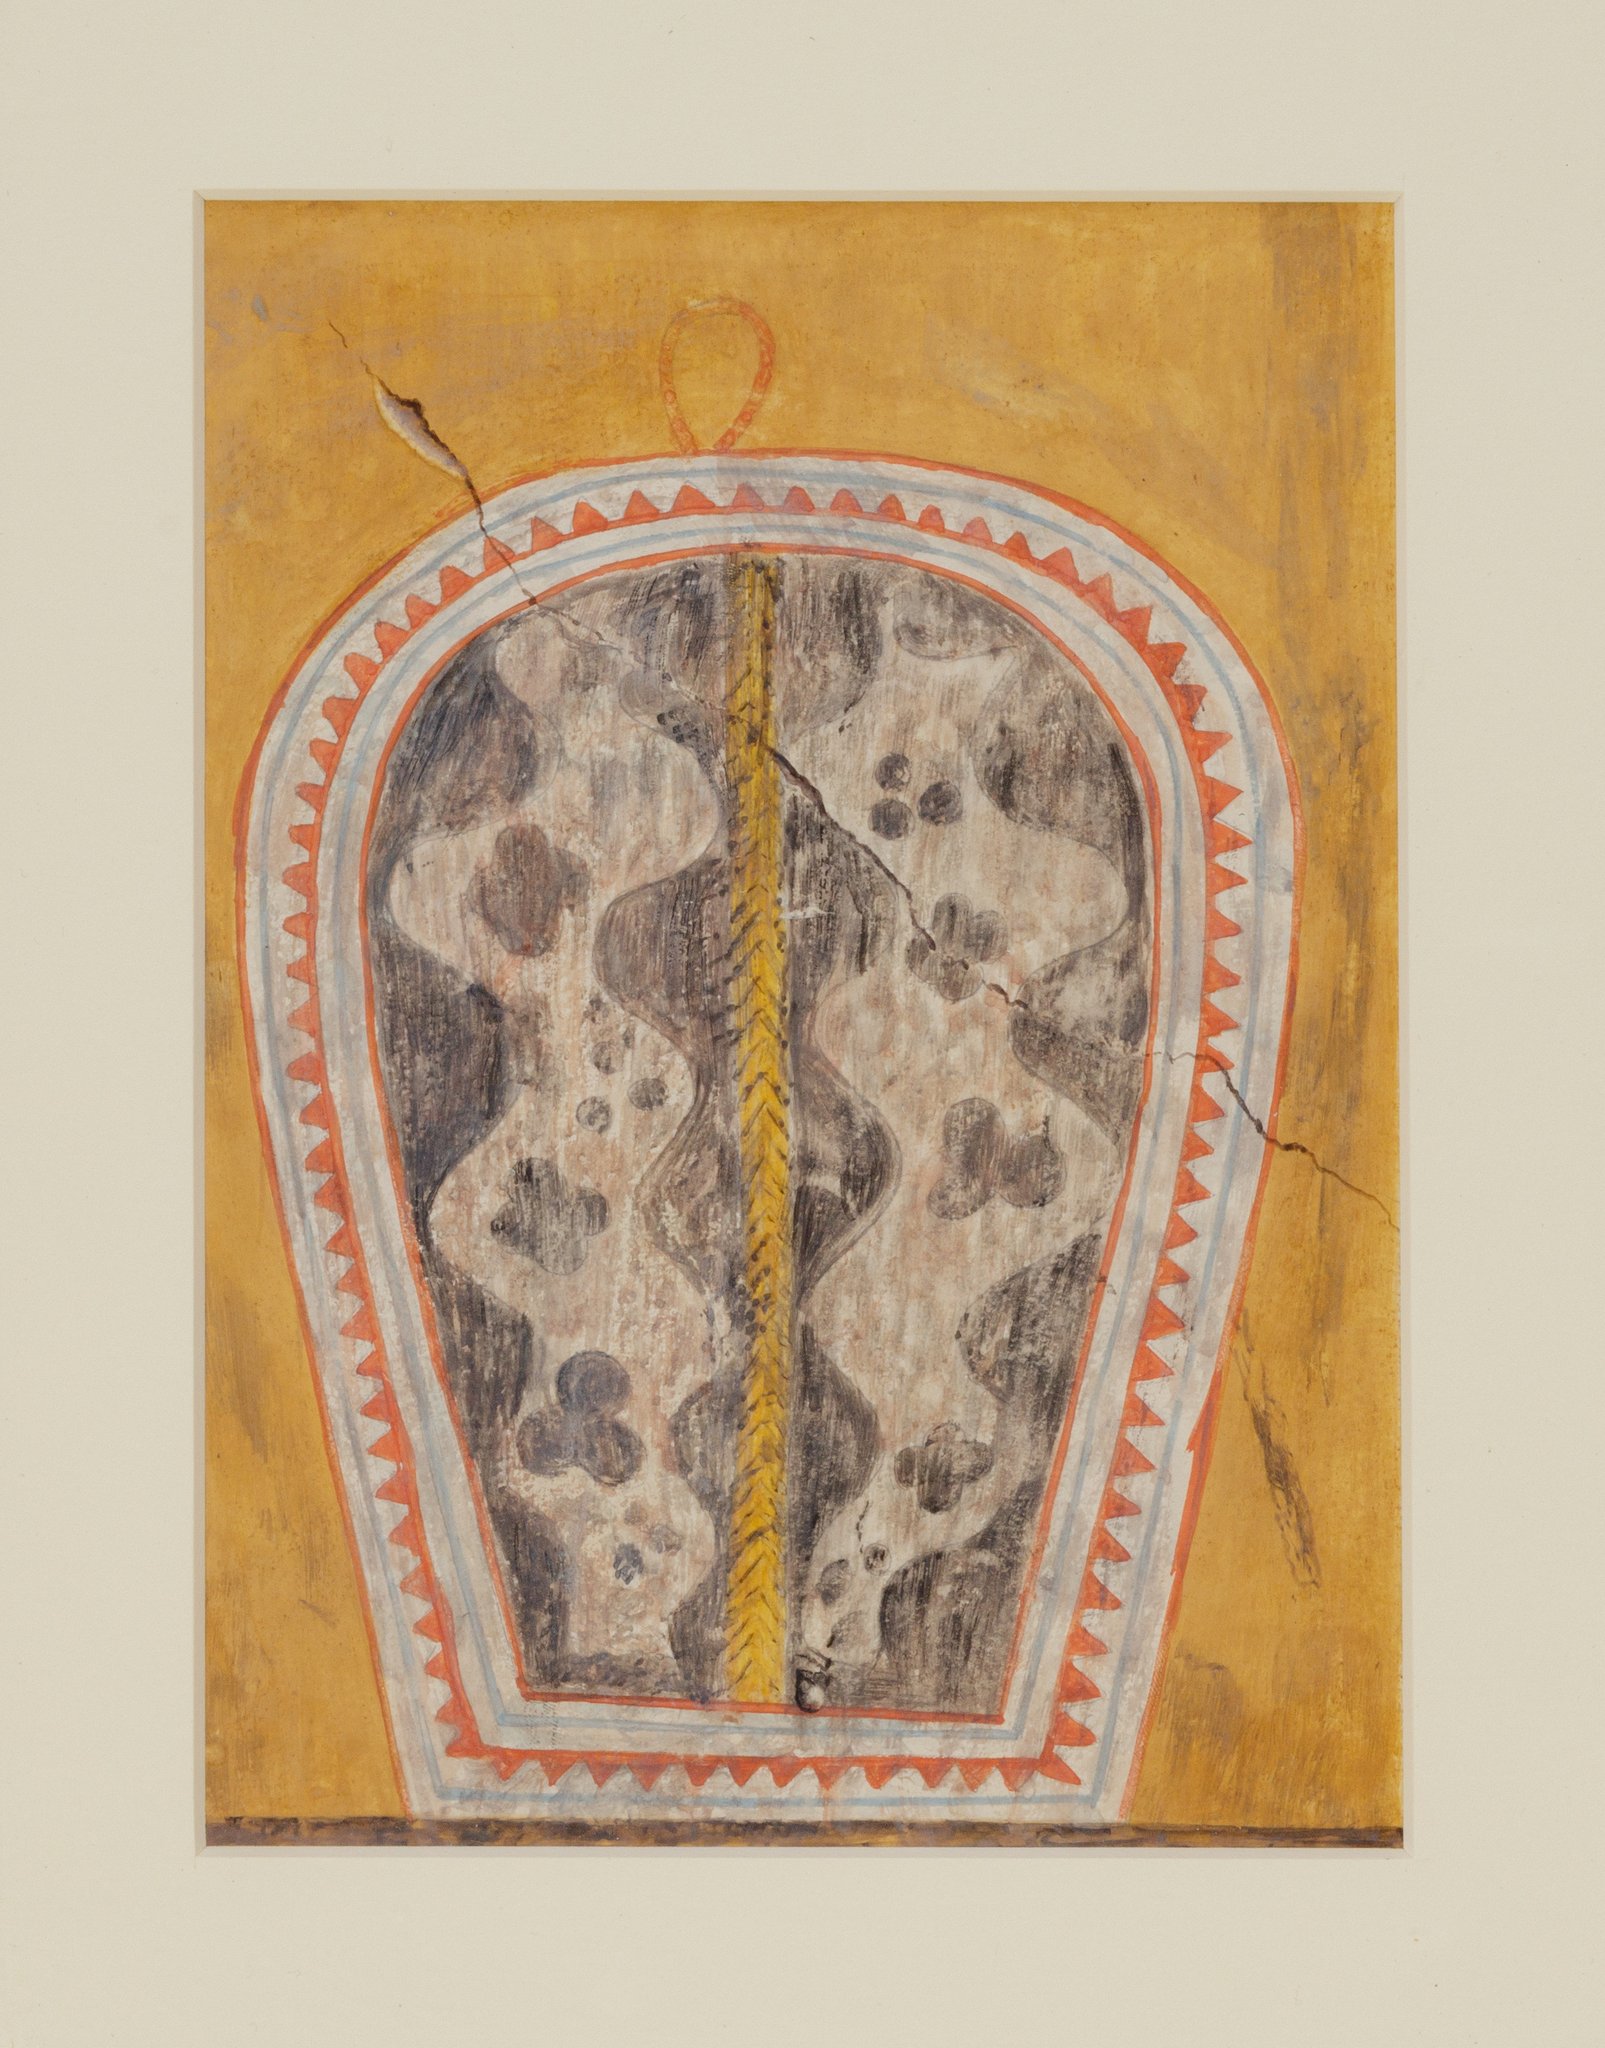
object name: facsimile, qenamun tt 93, shield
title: New Year Gift: Shield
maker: norman de garis davies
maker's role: artist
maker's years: 1865-1941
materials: paper, paint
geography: egypt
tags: drink-and-be-merry